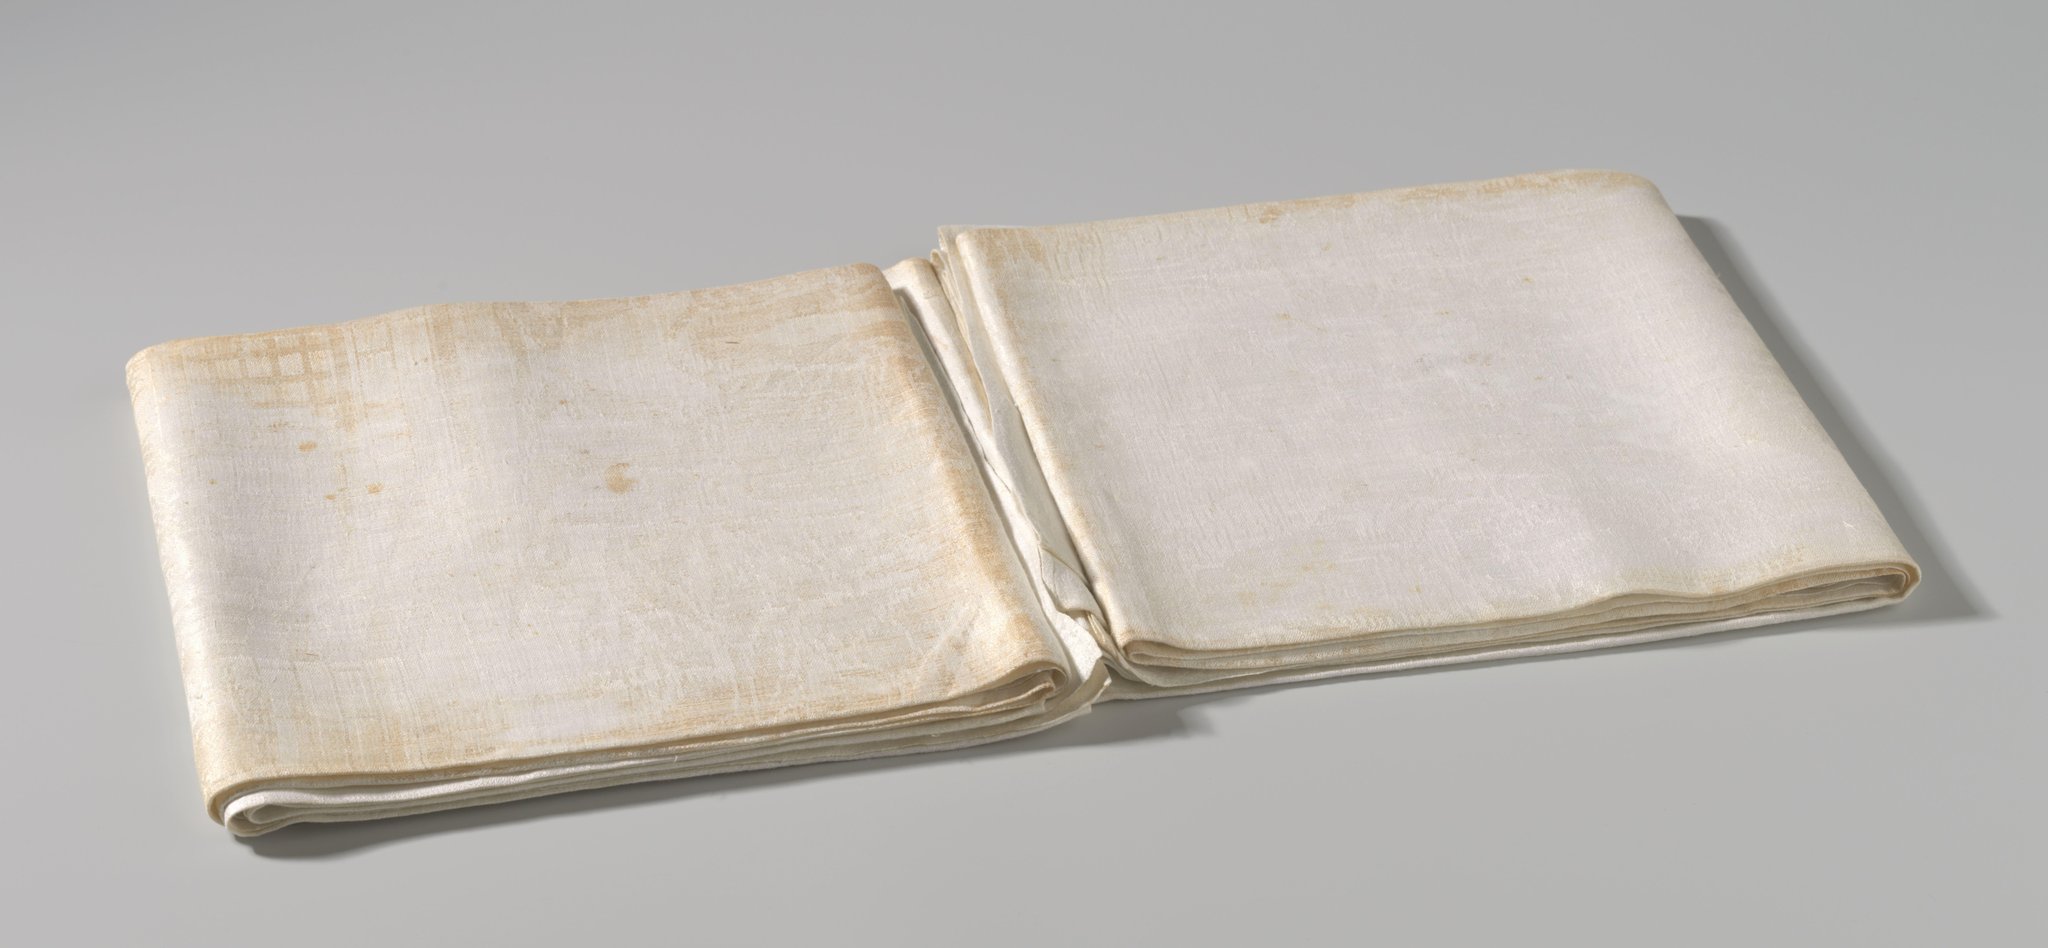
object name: tablecloth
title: Tafellaken met de geschiedenis van Johannes de Doper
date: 1590-1599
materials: linen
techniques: damask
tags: series of scenes from the life of john the baptist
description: Tafellaken van linnendamast met de geschiedenis van Johannes de Doper. Middenveld: het symmetrische, driemaal in de breedte herhaalde patroon vertoont van onder naar boven vijf taferelen: 1 Johannes predikt in de woestijn. Johannes, met haren kleed en barrevoets, staat met uitgebreide armen temidden van een menigte in een heuvellandschap. Een van hen draagt een wambuis en ballonbroek, een ander een platte bonnet. Onderschrift± MATTH.III.CAP. 2 Doop van Christus in de Jordaan. In het midden de duif in stralen boven een palmboom, die op een eiland groeit van het water, waarin Christus staat met gebogen hoofd, gekruiste armen en lendendoek. De op de oever geknielde Johannes, met kruisstaf, besprenkelt het gebaarde hoofd. Boven hem een loofboom waarin: MARCI.I.CA. 3 Onthoofding in de gevangenis. Voor een terugspringende muur met getraliede vernsters staat de scherprechter, voor wiens voeten het onthoofde lichaam van Johannes voorover ligt, hij legt het hoofd op de schotel, die Salomé draagt. Zij is gekleed in lang kleed met opgeschort bovenkleed, vierkante splithals, lange onder- en korte bovenmouw. Onderschrift: MARCI.VI.CA. 4 en 5 zijn een herhaling van de taferelen 1 en 2 (gehalveerd). Staande randen: spiegelbeeldig verdubbeld en door een lijn gescheiden spits ovaal rankensysteem met spiraalvertakkingen, waaraan bloemen en vruchten; daarbuiten: blokkenrand.